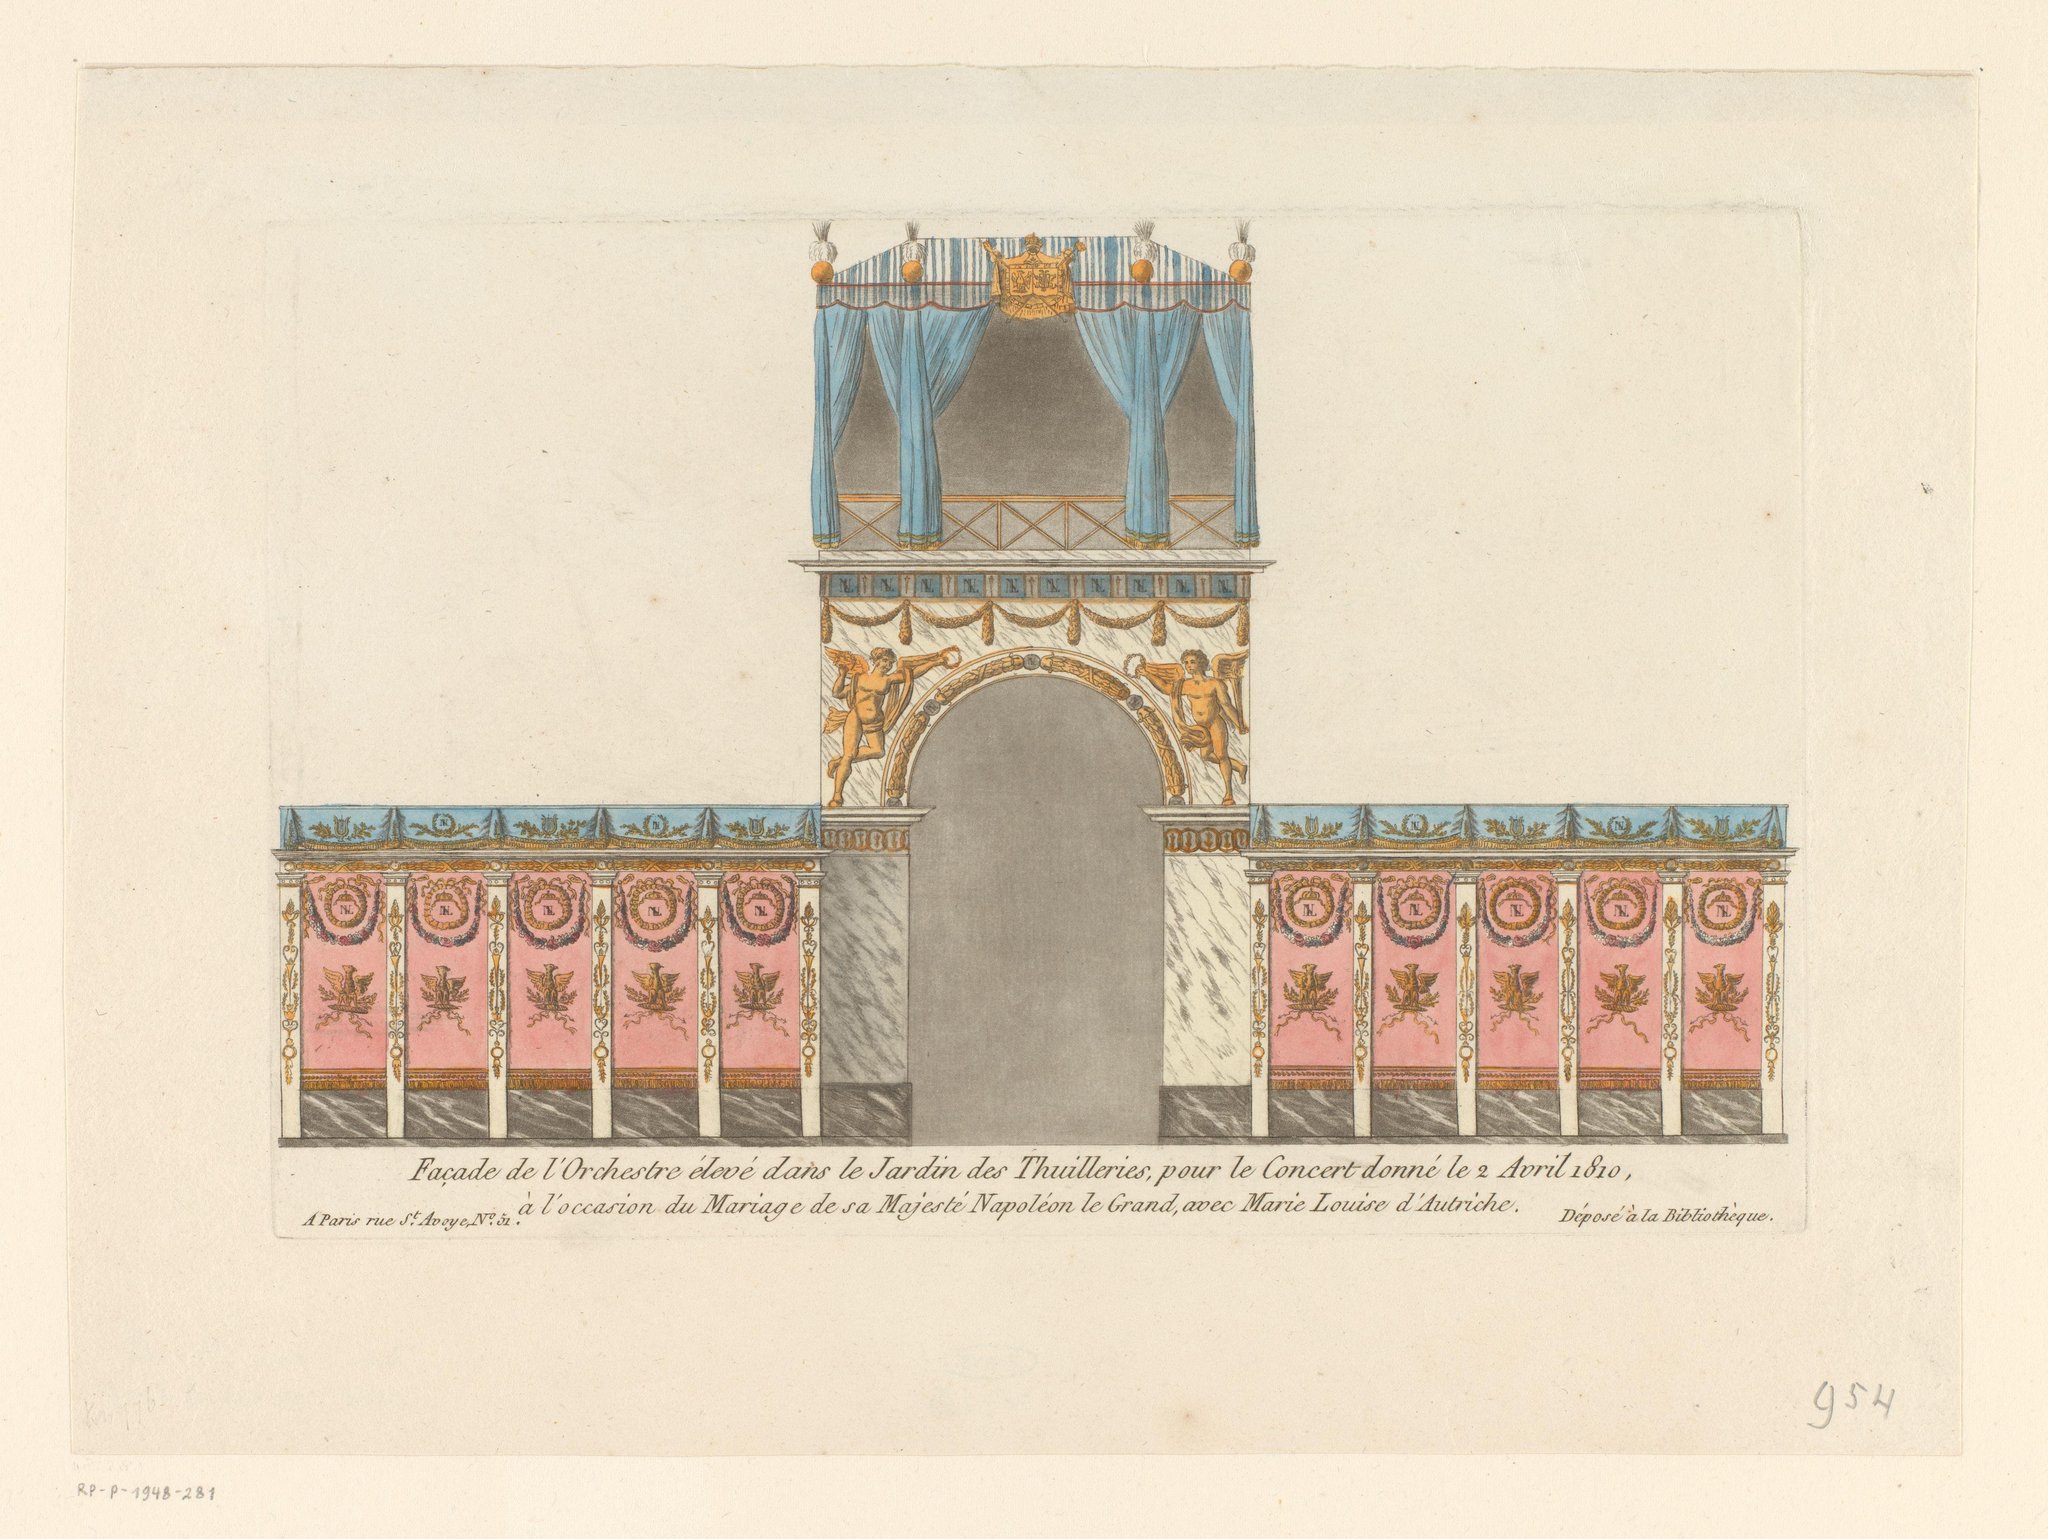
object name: print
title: Façade van een podium in de Tuilerieën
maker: Anonymous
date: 1810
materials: paper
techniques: etching, hand coloring, roulette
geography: paris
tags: parts of church exterior and annexes: façade, stage design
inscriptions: collector's mark: Lugt 2228, : ‘Déposé à la Bibliothèque’, watermark